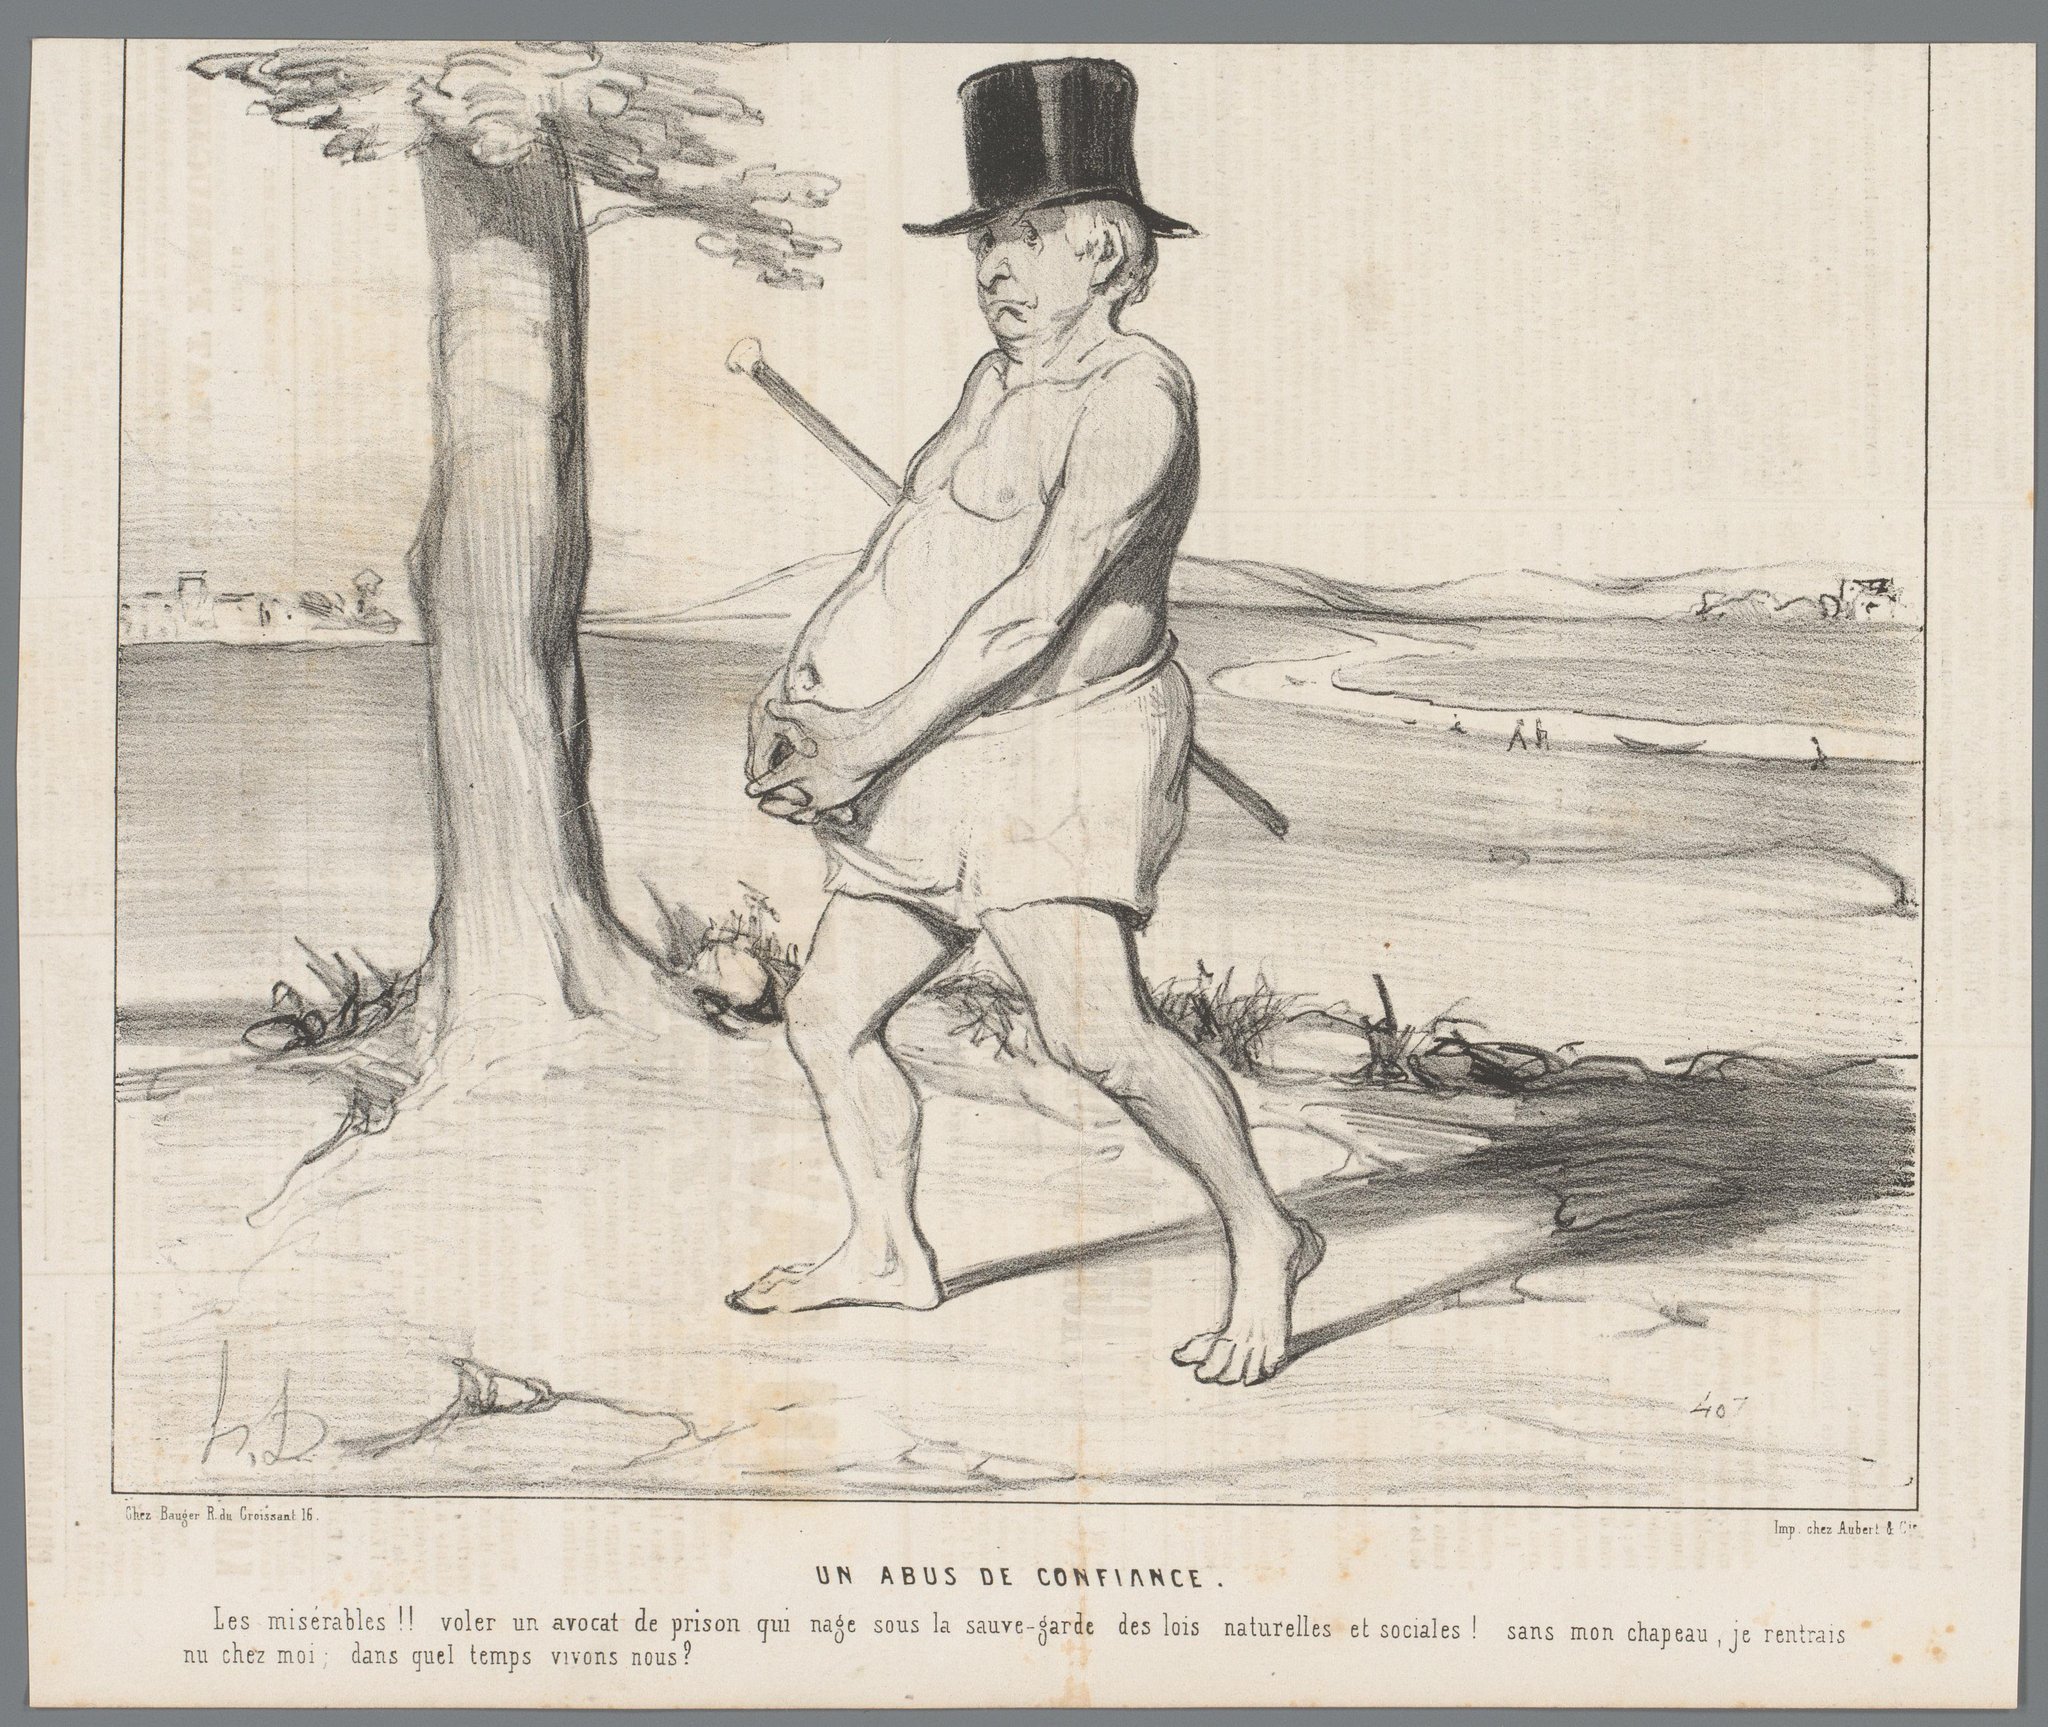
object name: print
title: Badende mannen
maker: honoré daumier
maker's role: draughtsman, painter, print maker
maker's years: 1808-1879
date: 1842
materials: paper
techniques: letterpress printing, lithograph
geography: paris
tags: caricatures (human types), adult man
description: Prent uit: Le Charivari, 2 september 1842.